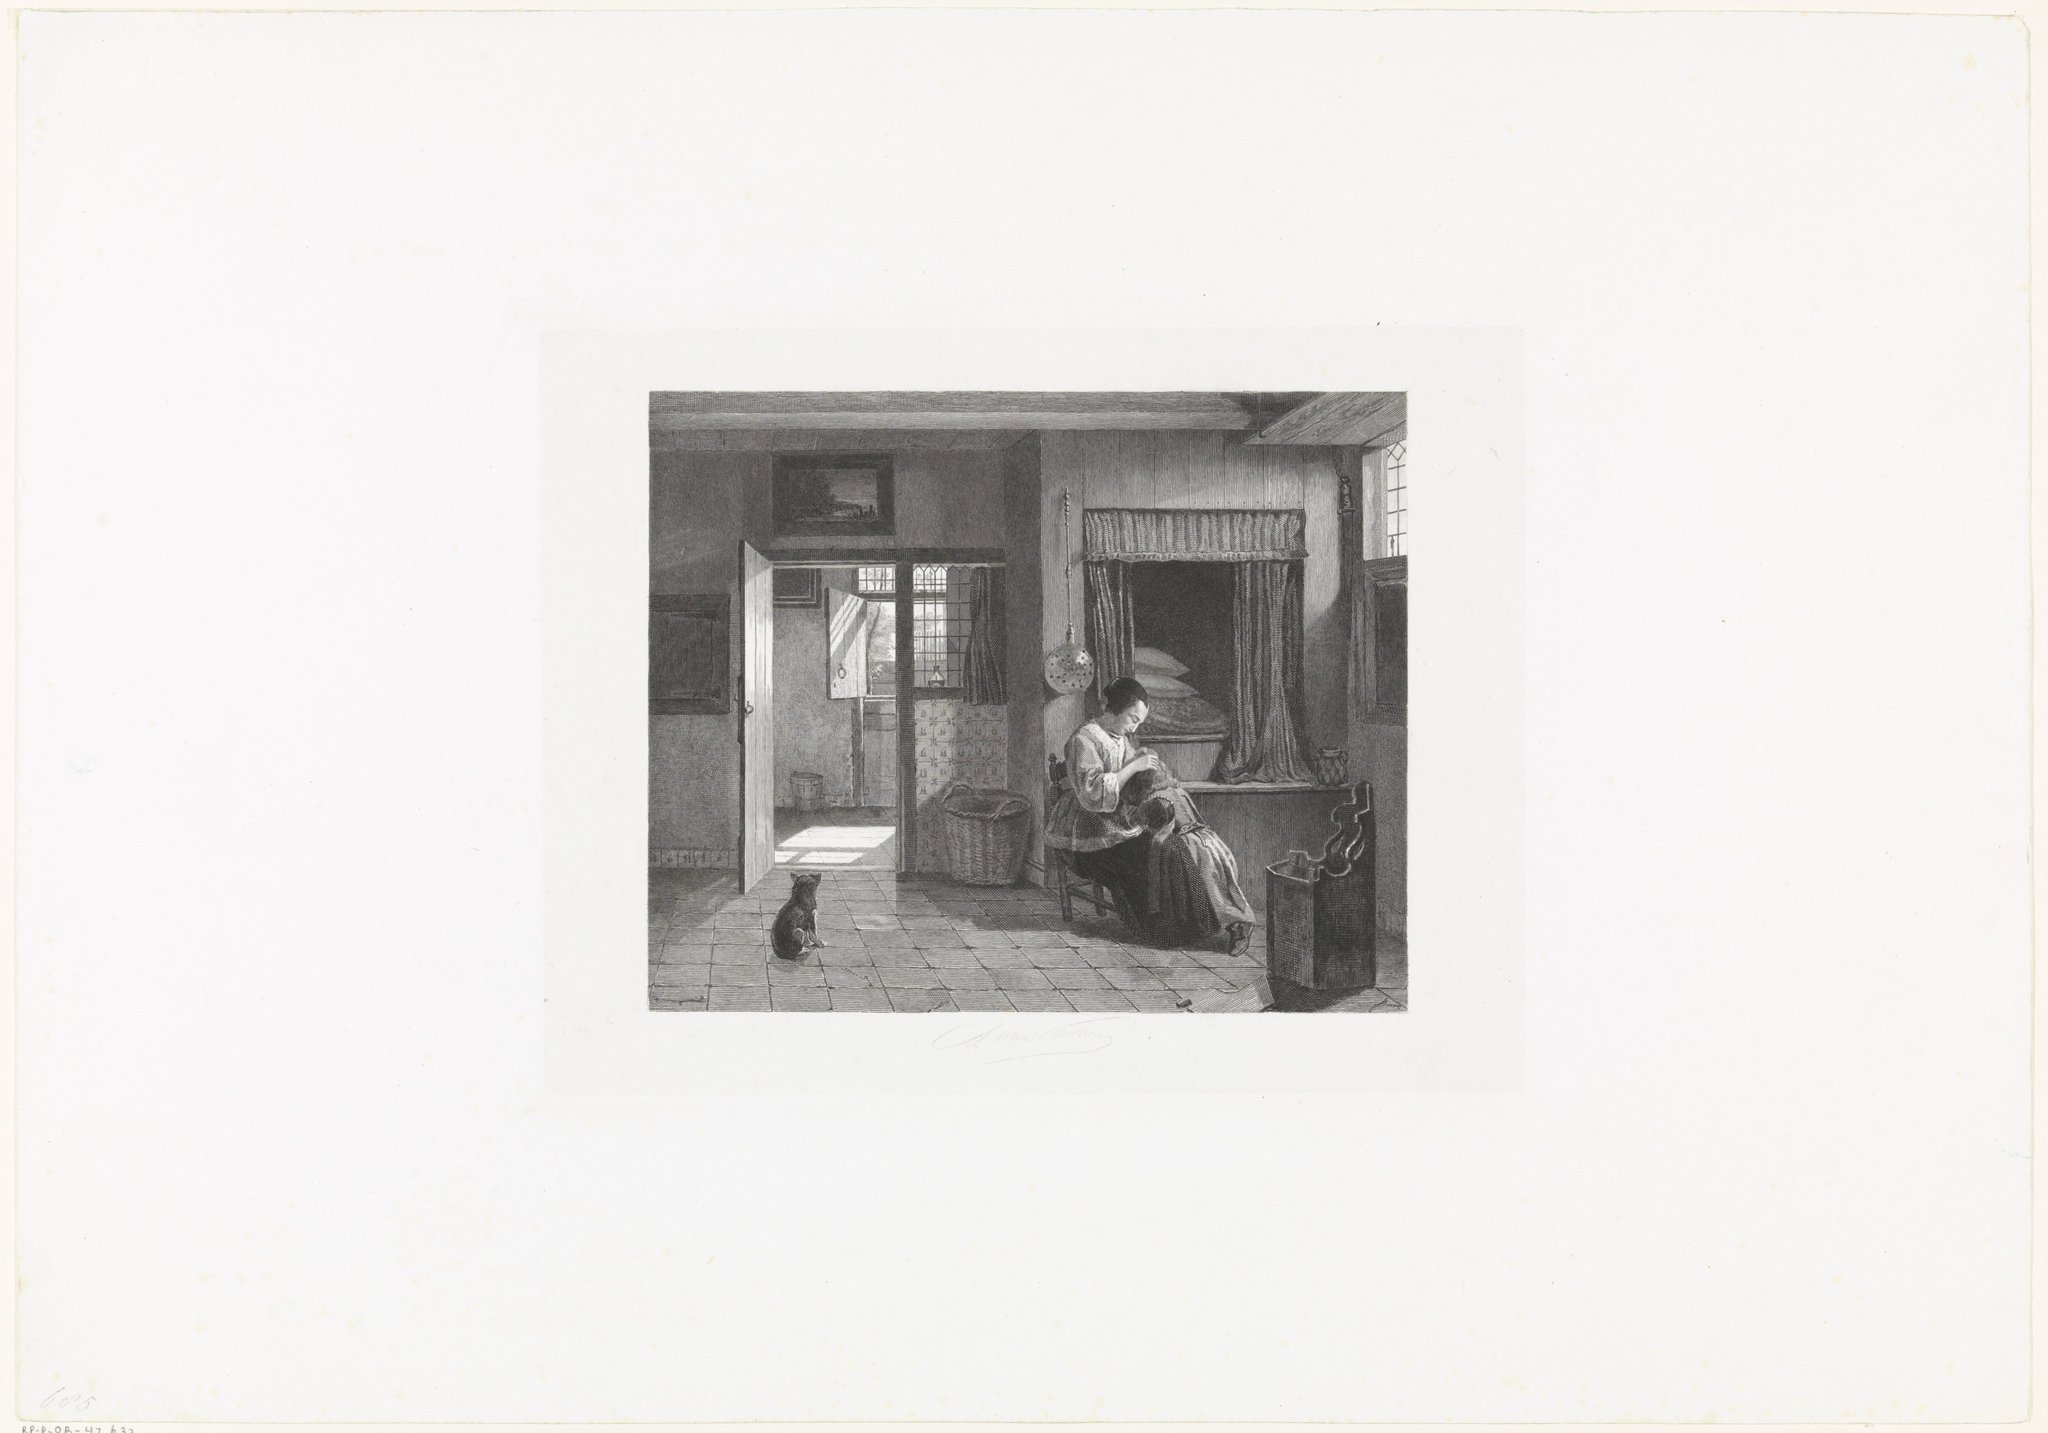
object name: print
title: Moeder die haar kind vlooit, bekend als ‘de Moedertaak'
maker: christiaan lodewijk van kesteren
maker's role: print maker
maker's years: 1832-1897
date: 1861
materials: paper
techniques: engraving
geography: amsterdam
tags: dog, 'motherly care', delousing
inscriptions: collector's mark: Lugt 2165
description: Deze prent is als illustratie gebruikt in: Christiaan Lodewĳk van Kesteren en Willem Jacob Hofdĳk. Museum Van der Hoop : 12 staalgravures naar de uitnemendste en belangrijkste schilderijen. Amsterdam : Wed. J.C. van Kesteren & Zoon. 1861.